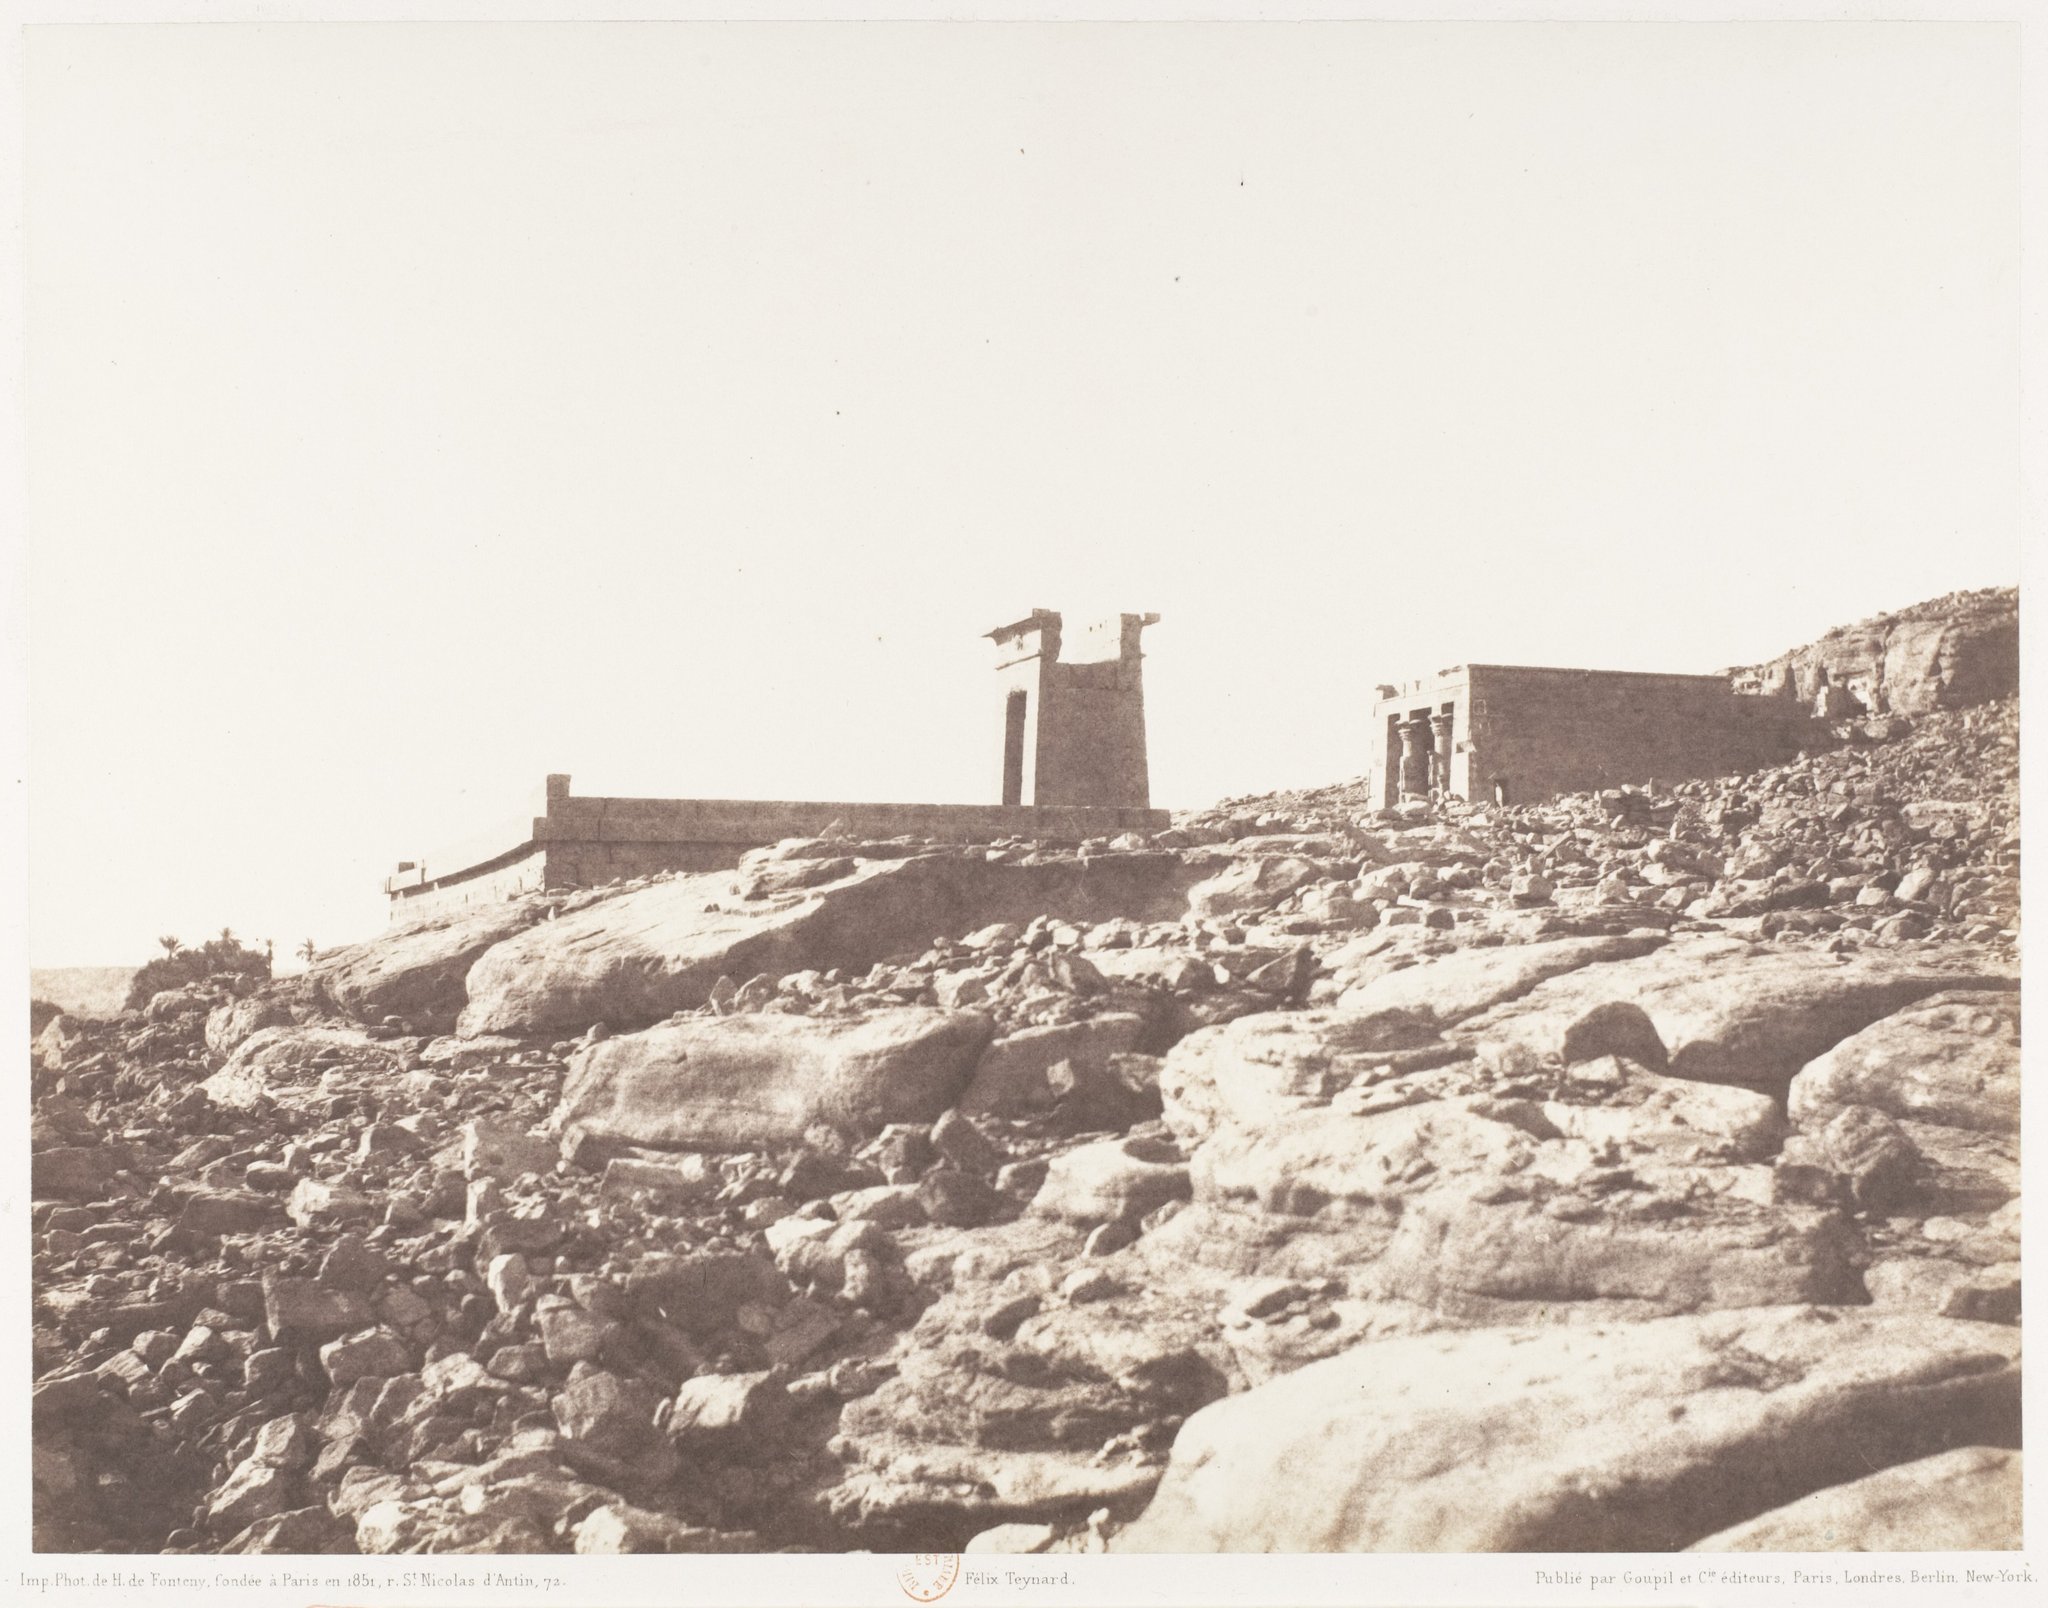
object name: photograph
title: Dandour, Vue Générale des Ruines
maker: félix teynard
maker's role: artist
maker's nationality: french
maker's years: 1817-1892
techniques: paper negative, salted paper print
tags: architecture,ruins